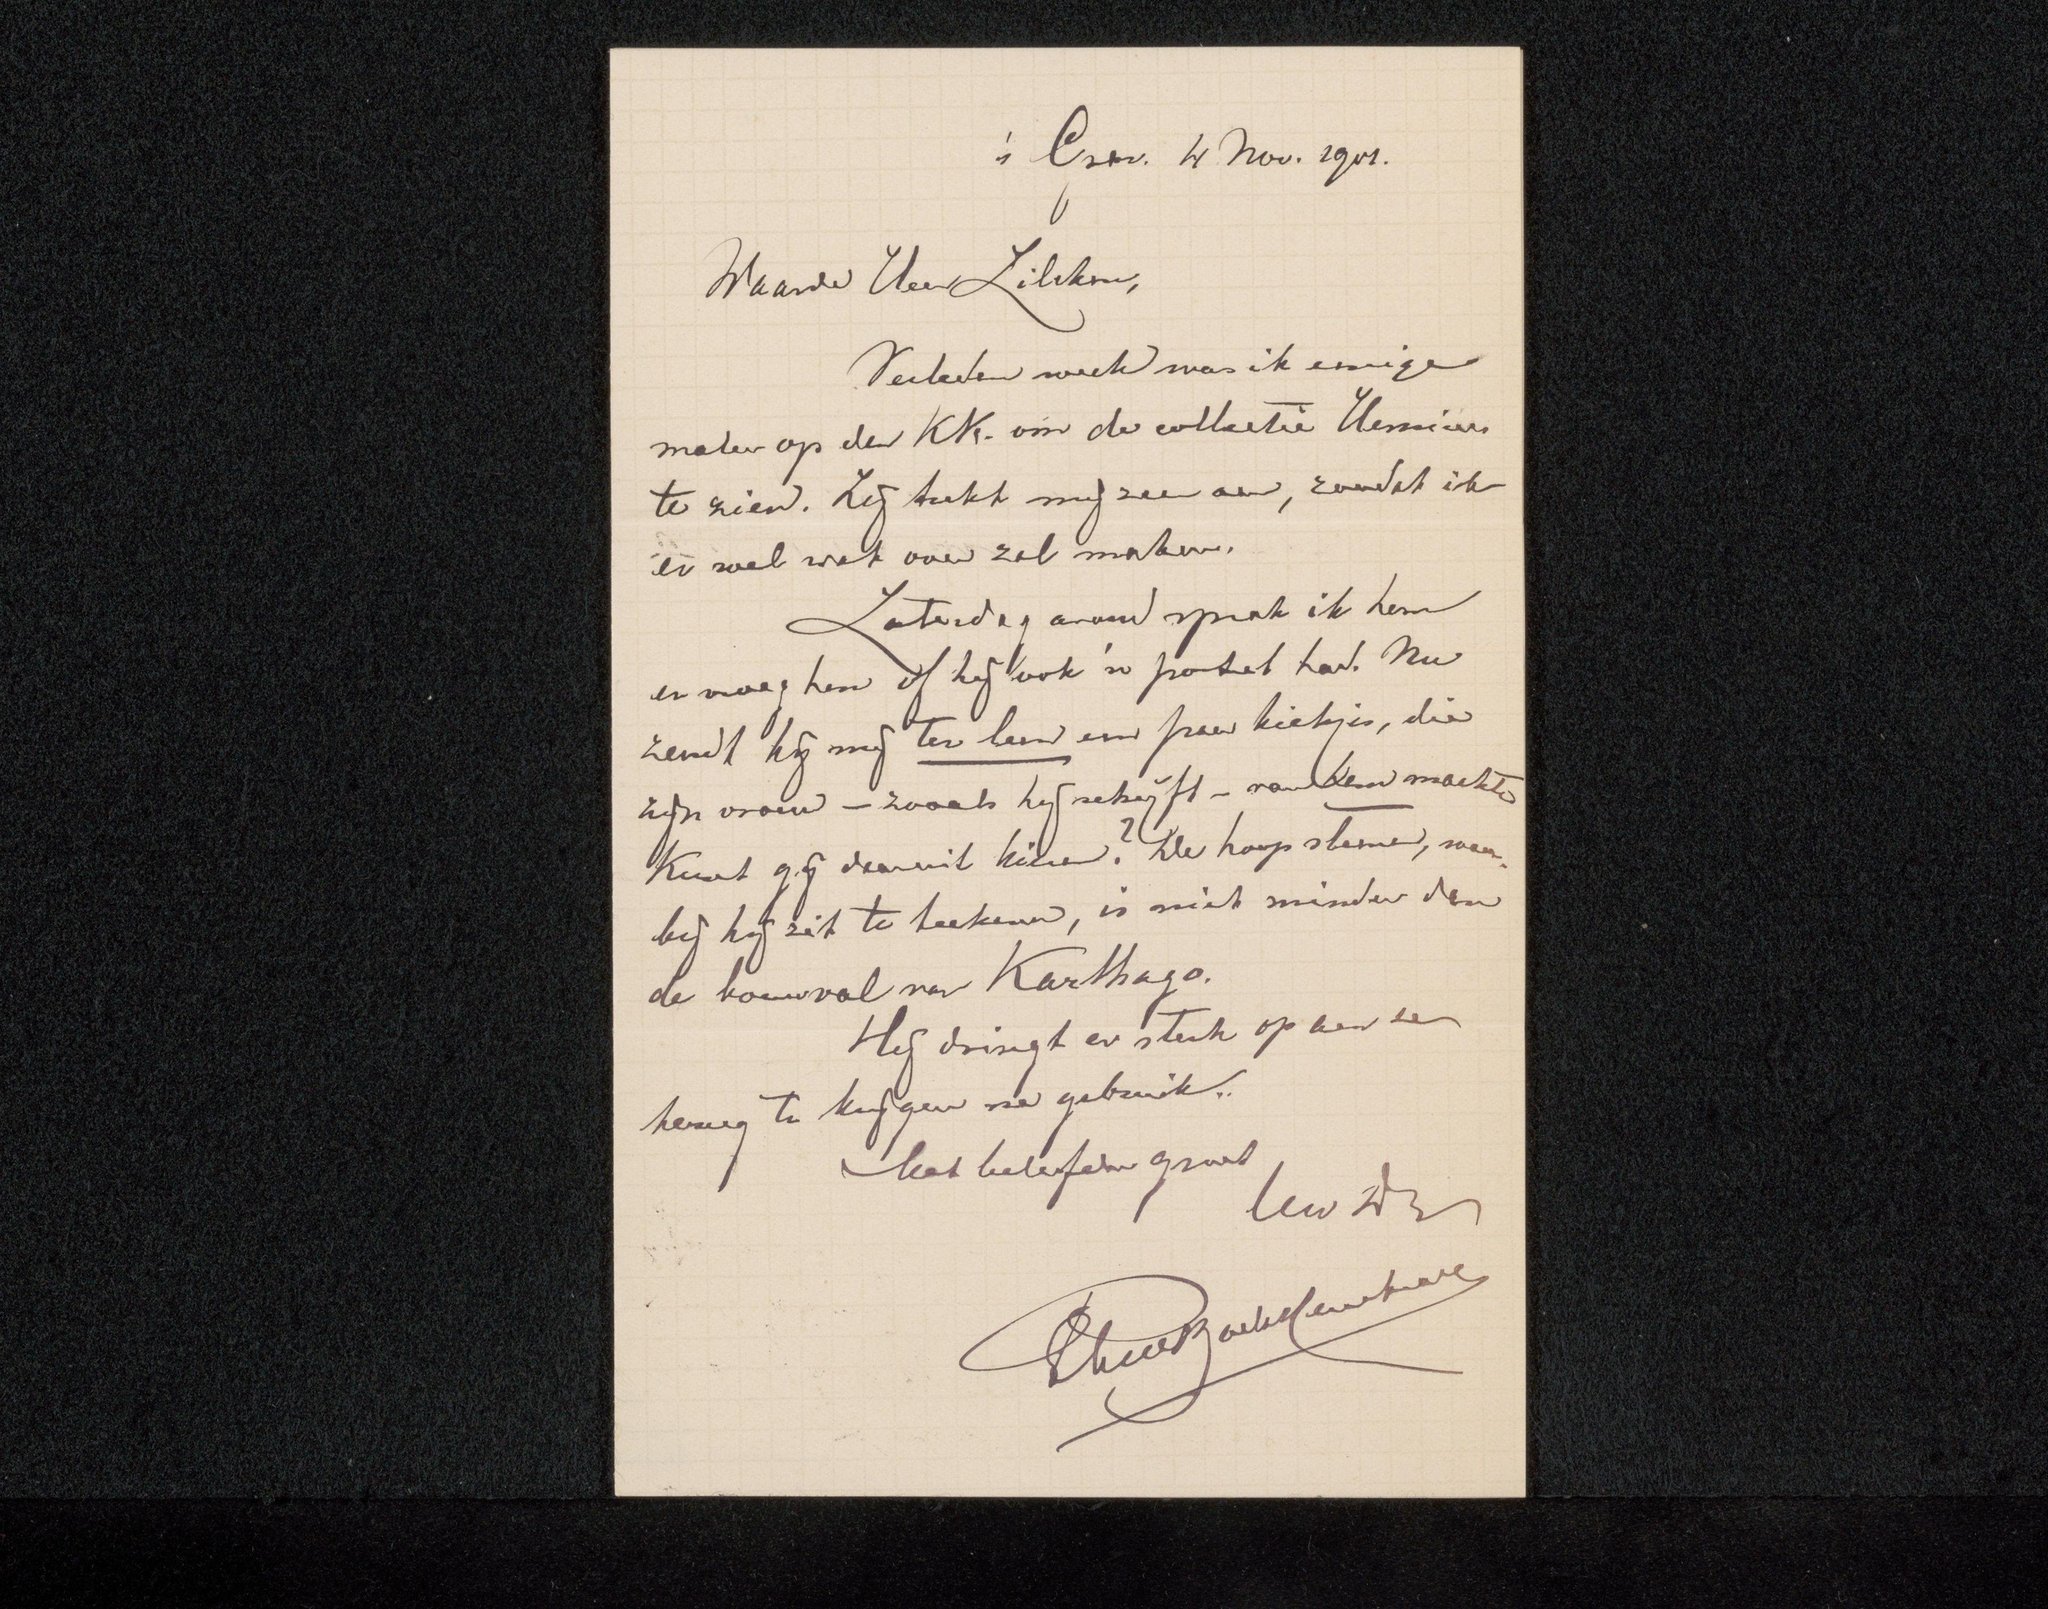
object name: letter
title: Brief aan Philip Zilcken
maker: pieter andreas martin boele van hensbroek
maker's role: publisher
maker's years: 1853-1912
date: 1901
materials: ink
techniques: pen, writing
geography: the hague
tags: the hague, painter, draughtsman, philip zilcken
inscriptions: collector's mark: ‘RPK’